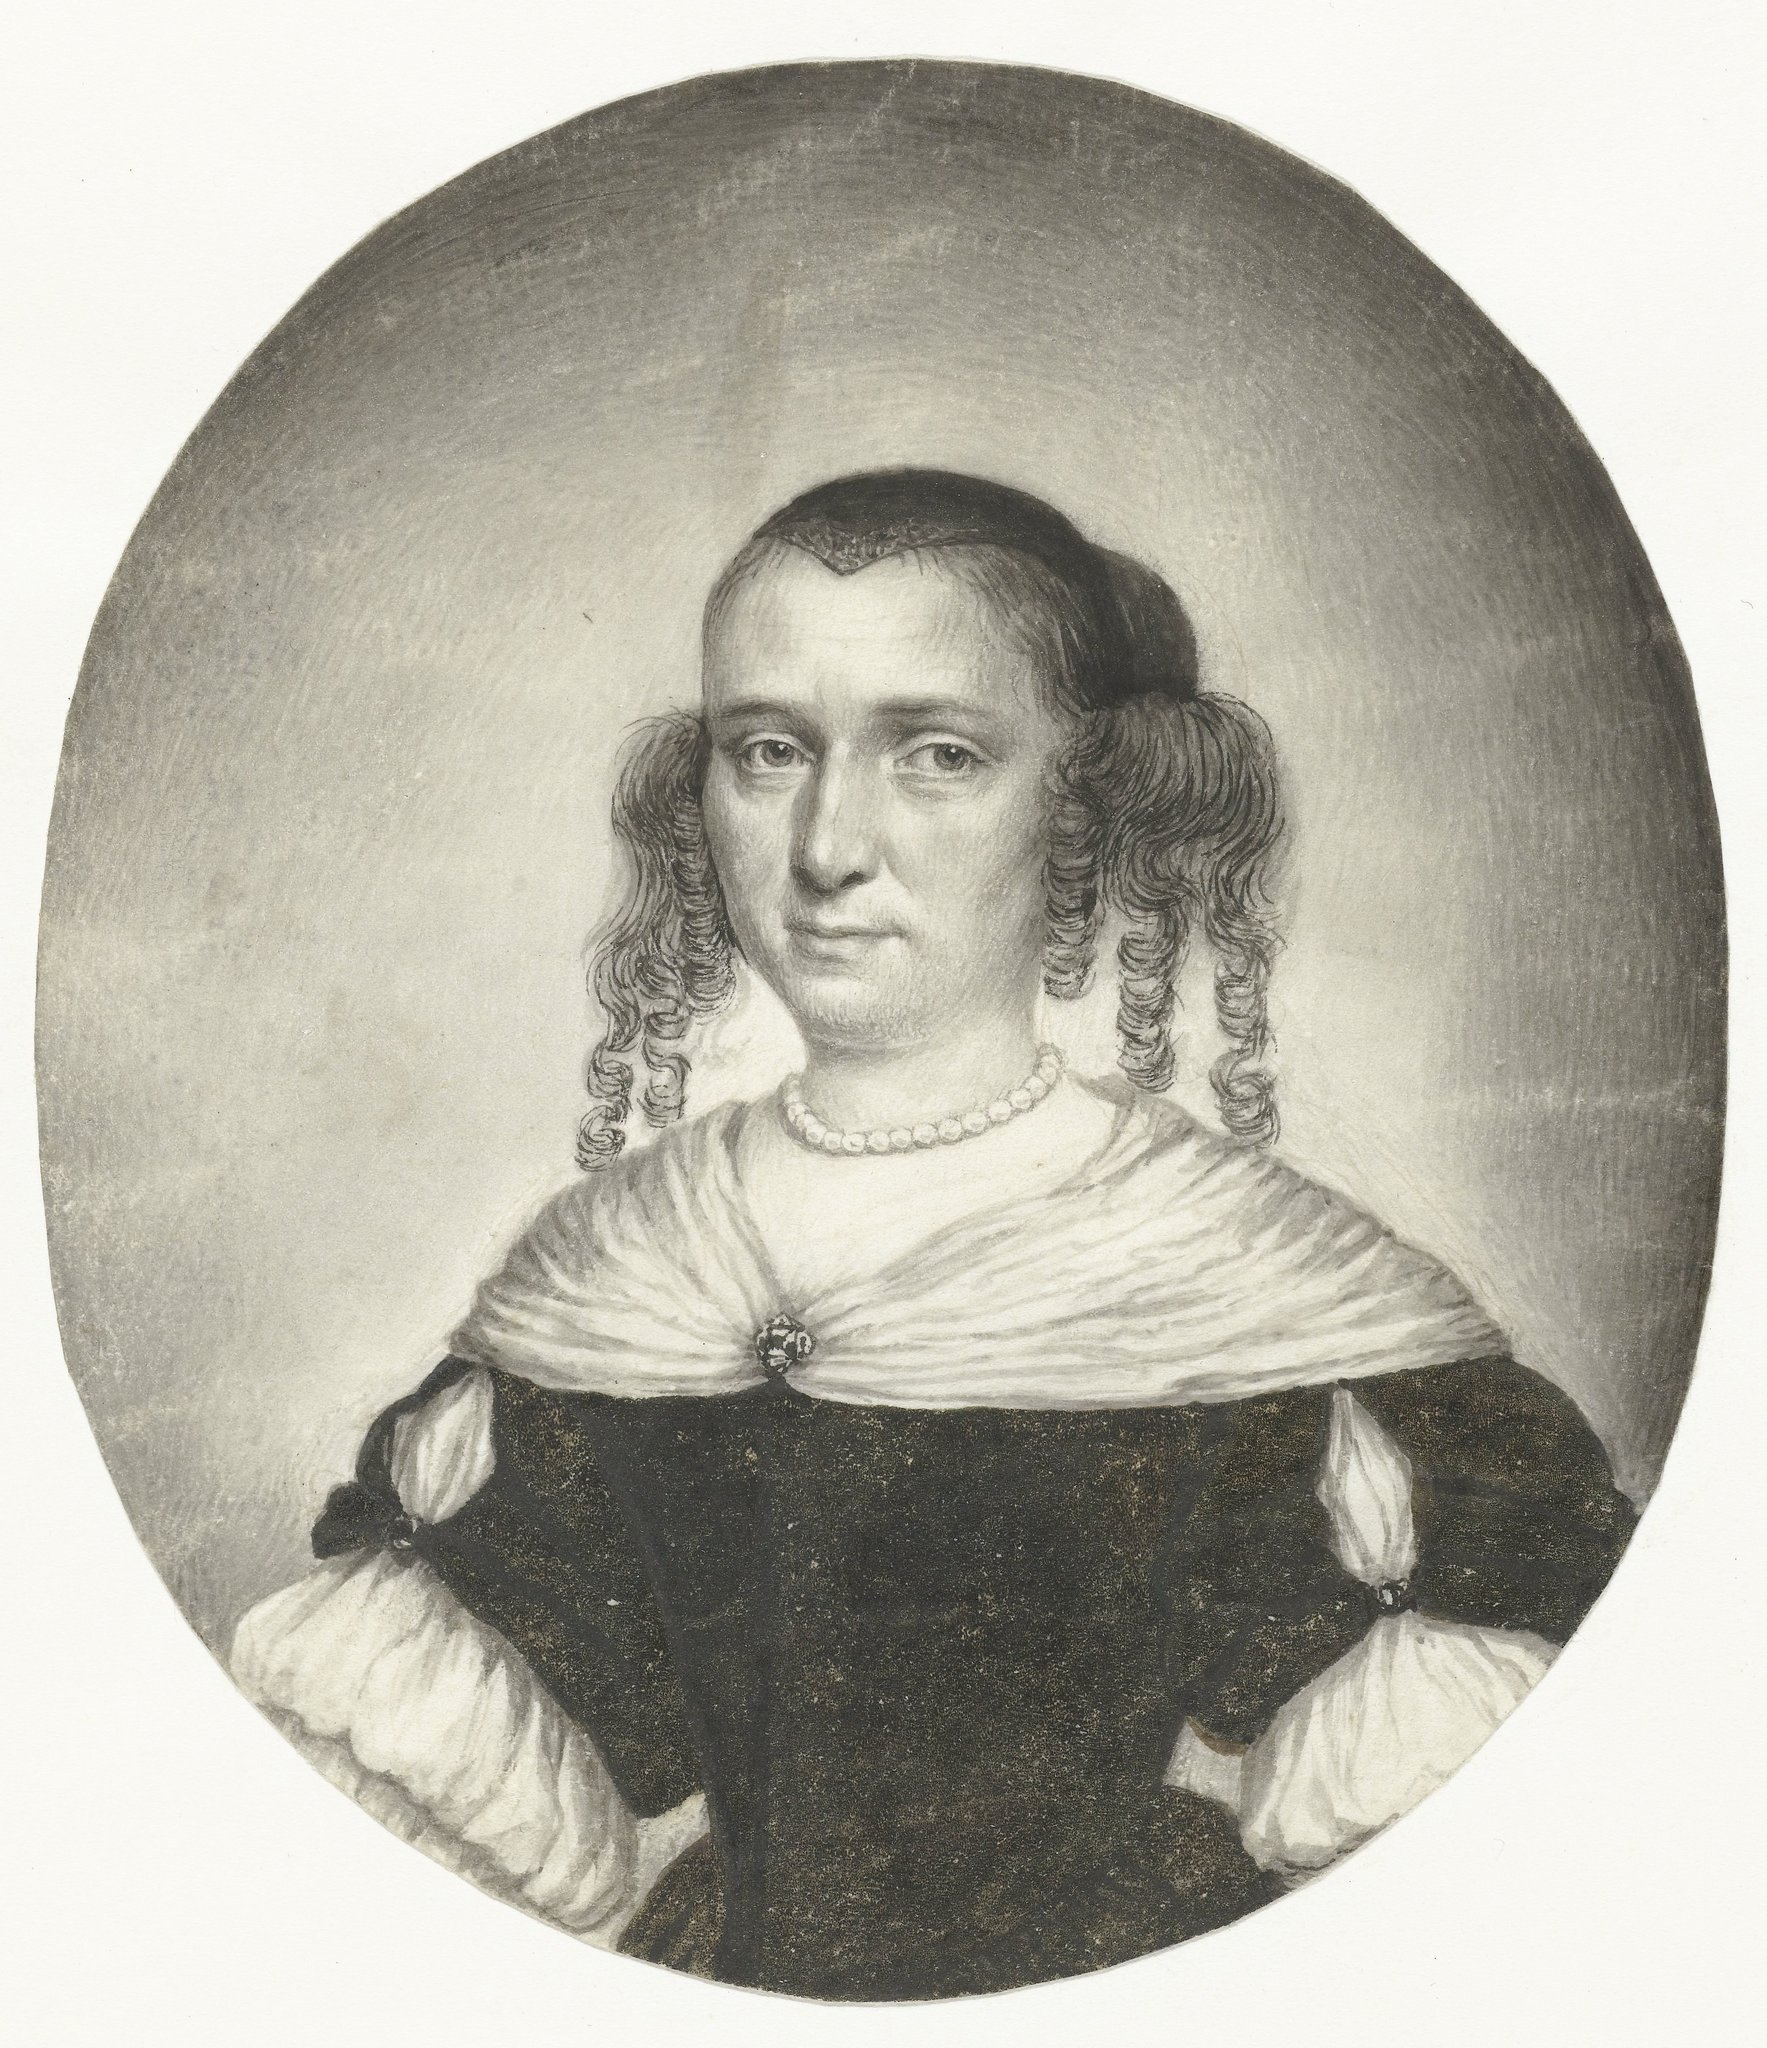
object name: drawing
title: Portret van een onbekende vrouw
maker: pieter cornelisz. van slingelandt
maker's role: draughtsman, painter, print maker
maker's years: 1640-1691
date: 1650-1691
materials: ink, parchment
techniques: brush, pen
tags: anonymous historical person portrayed alone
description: Pendant van "Portret van een onbekende man", inventarisnummer RP-T-1903-A-4763.